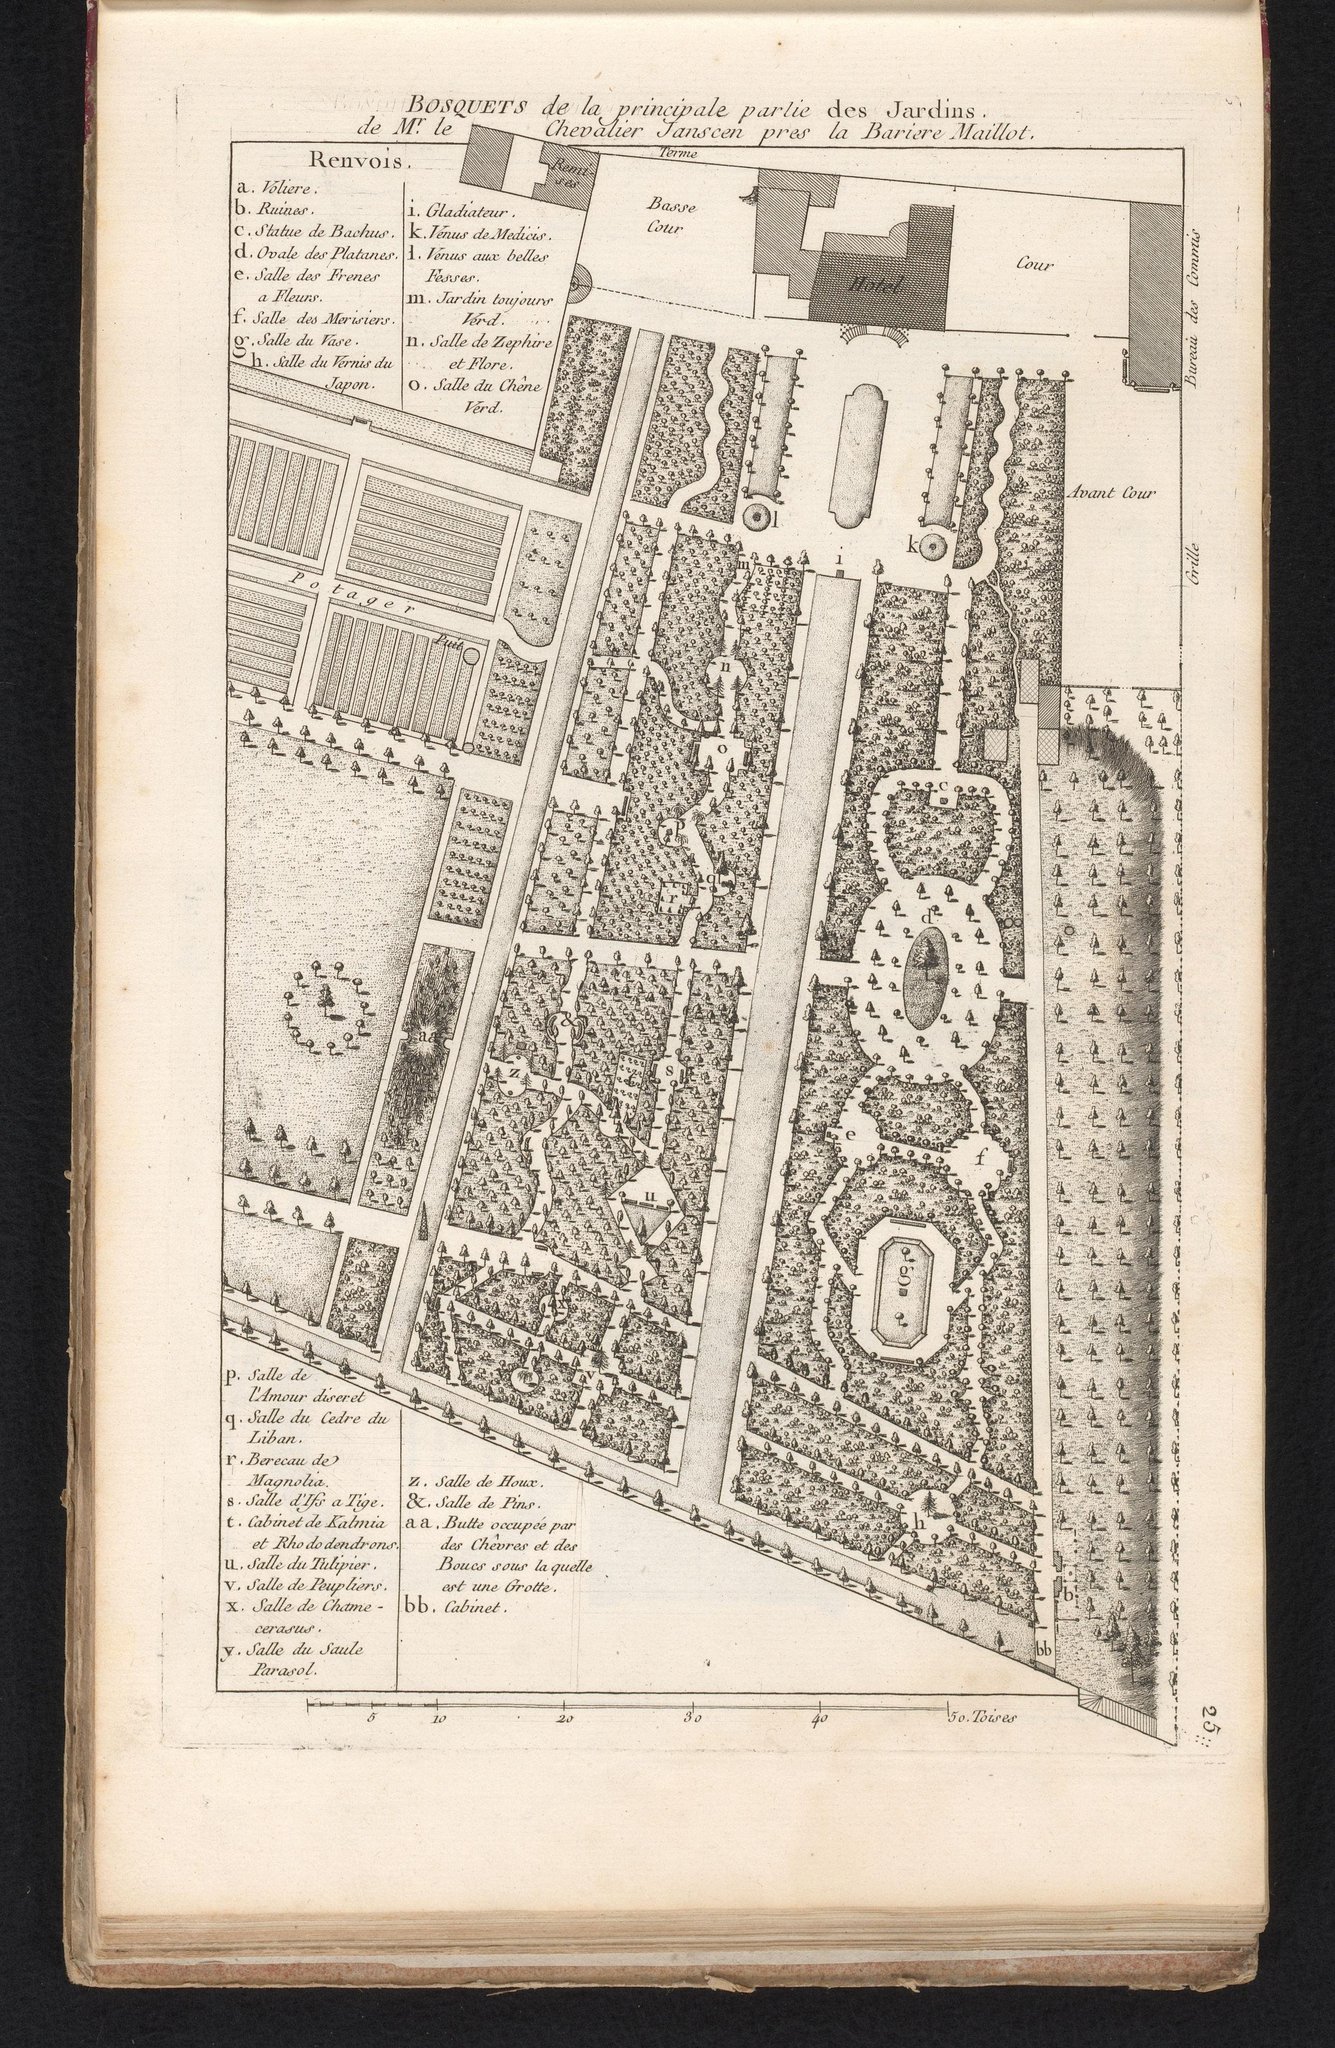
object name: album leaf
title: Plattegrond van de tuin van het Hôtel de Jansen in Parijs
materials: paper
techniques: engraving, etching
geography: paris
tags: plan, map of garden, paris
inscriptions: collector's mark: Lugt 2228, collector's mark: Lugt 2760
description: De serie 'Jardins anglo-chinois à la mode' verscheen in totaal in 21 zogeheten 'cahiers' (afleveringen). De huidige prent komt uit het zesde 'cahier'. Het Rijksmuseum Amsterdam bezit drie banden met daarin in totaal zes 'cahiers' van deze reeks. In de documentatie wordt verwezen naar een in de bibliotheek van het Rijksmuseum Amsterdam aanwezige facsimile van het complete werk.